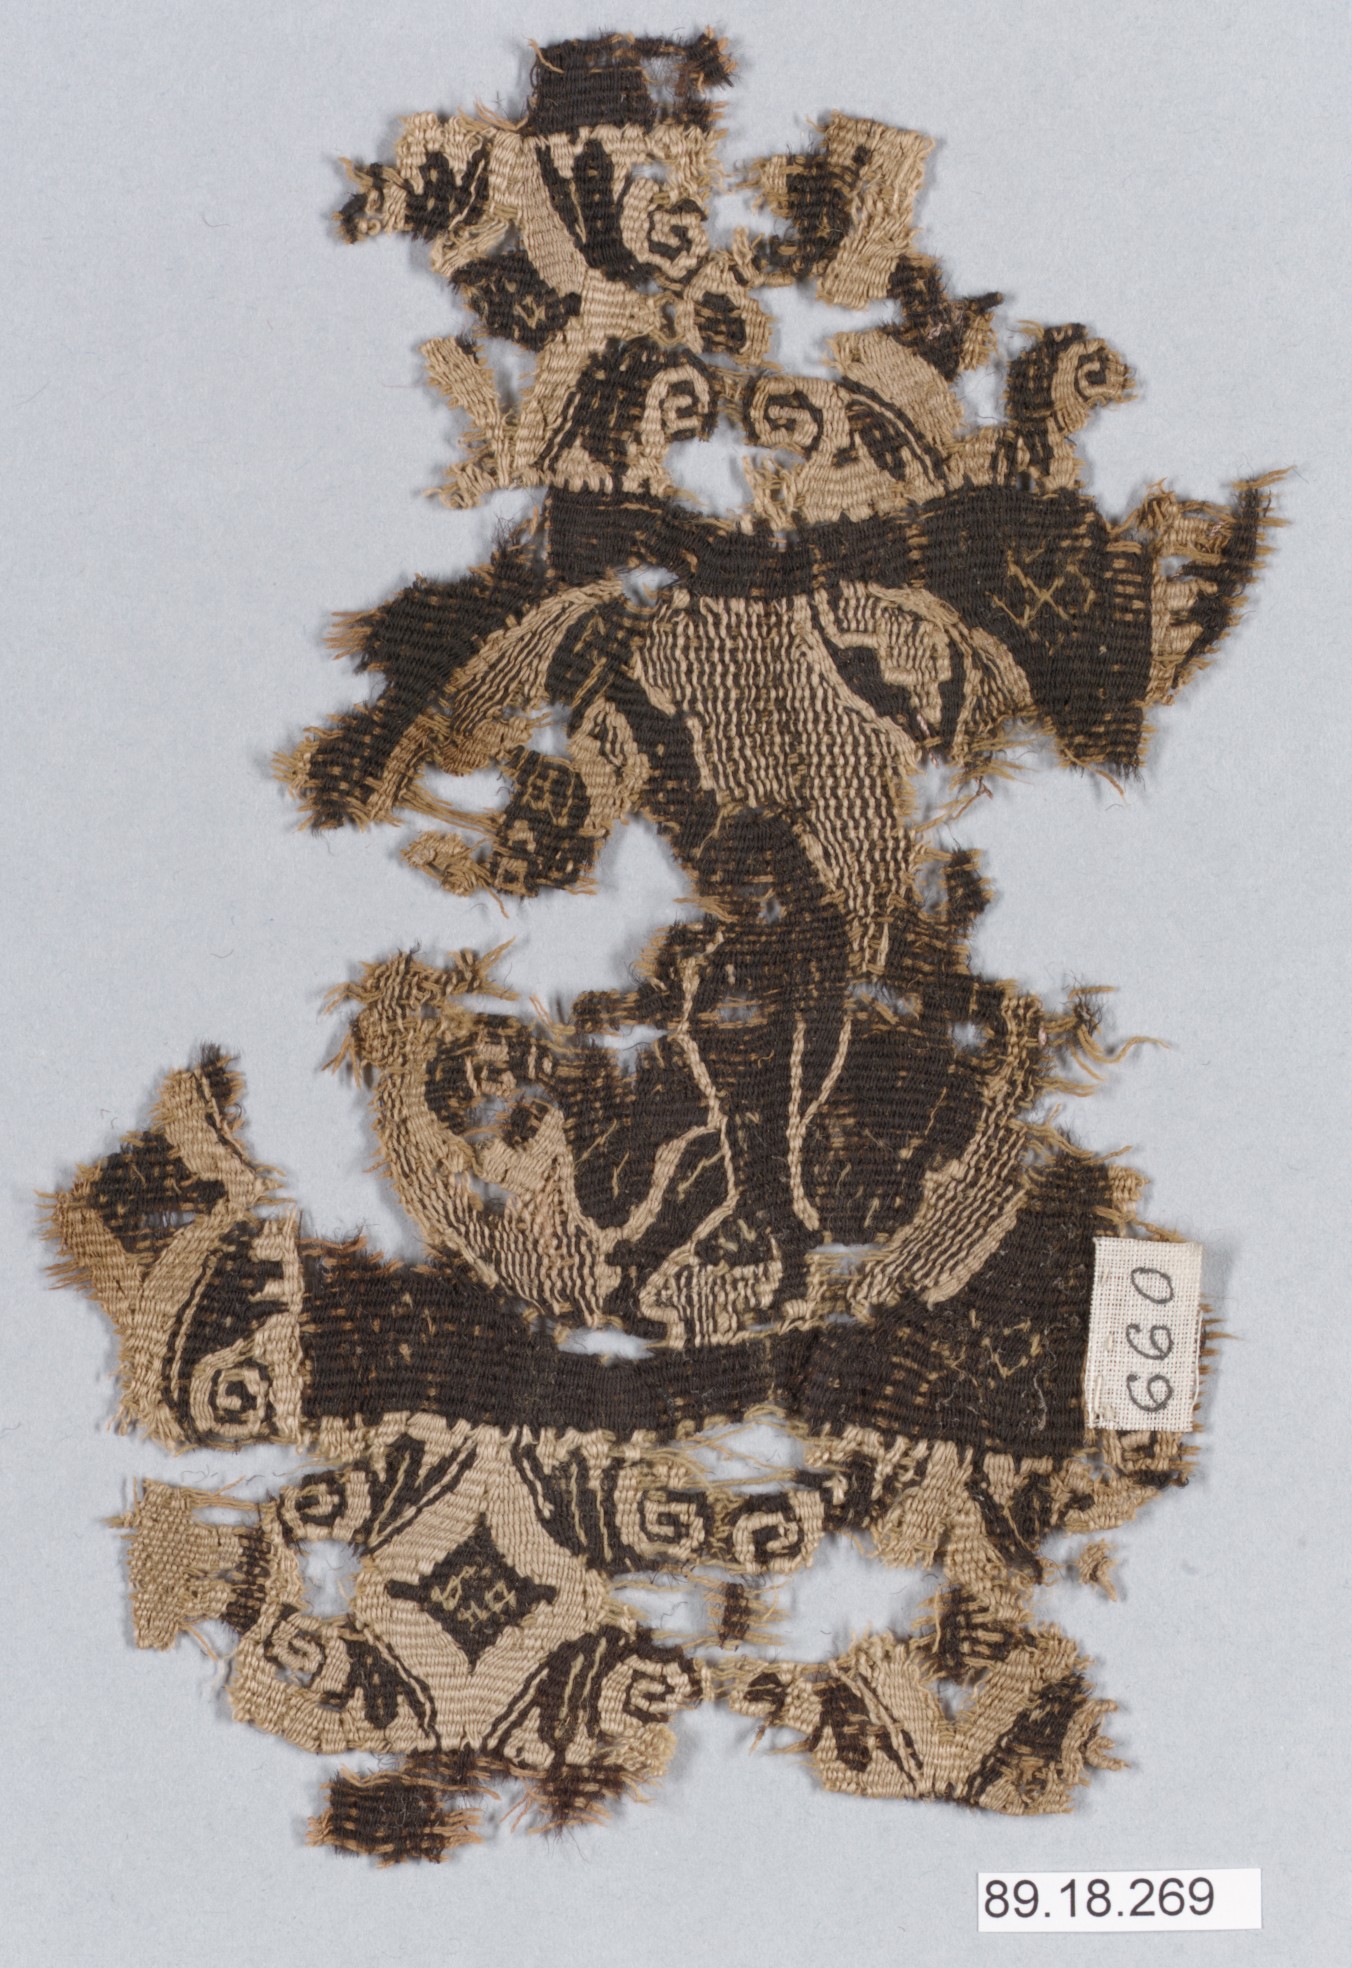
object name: textile fragment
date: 201-400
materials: linen, wool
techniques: weave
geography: egypt